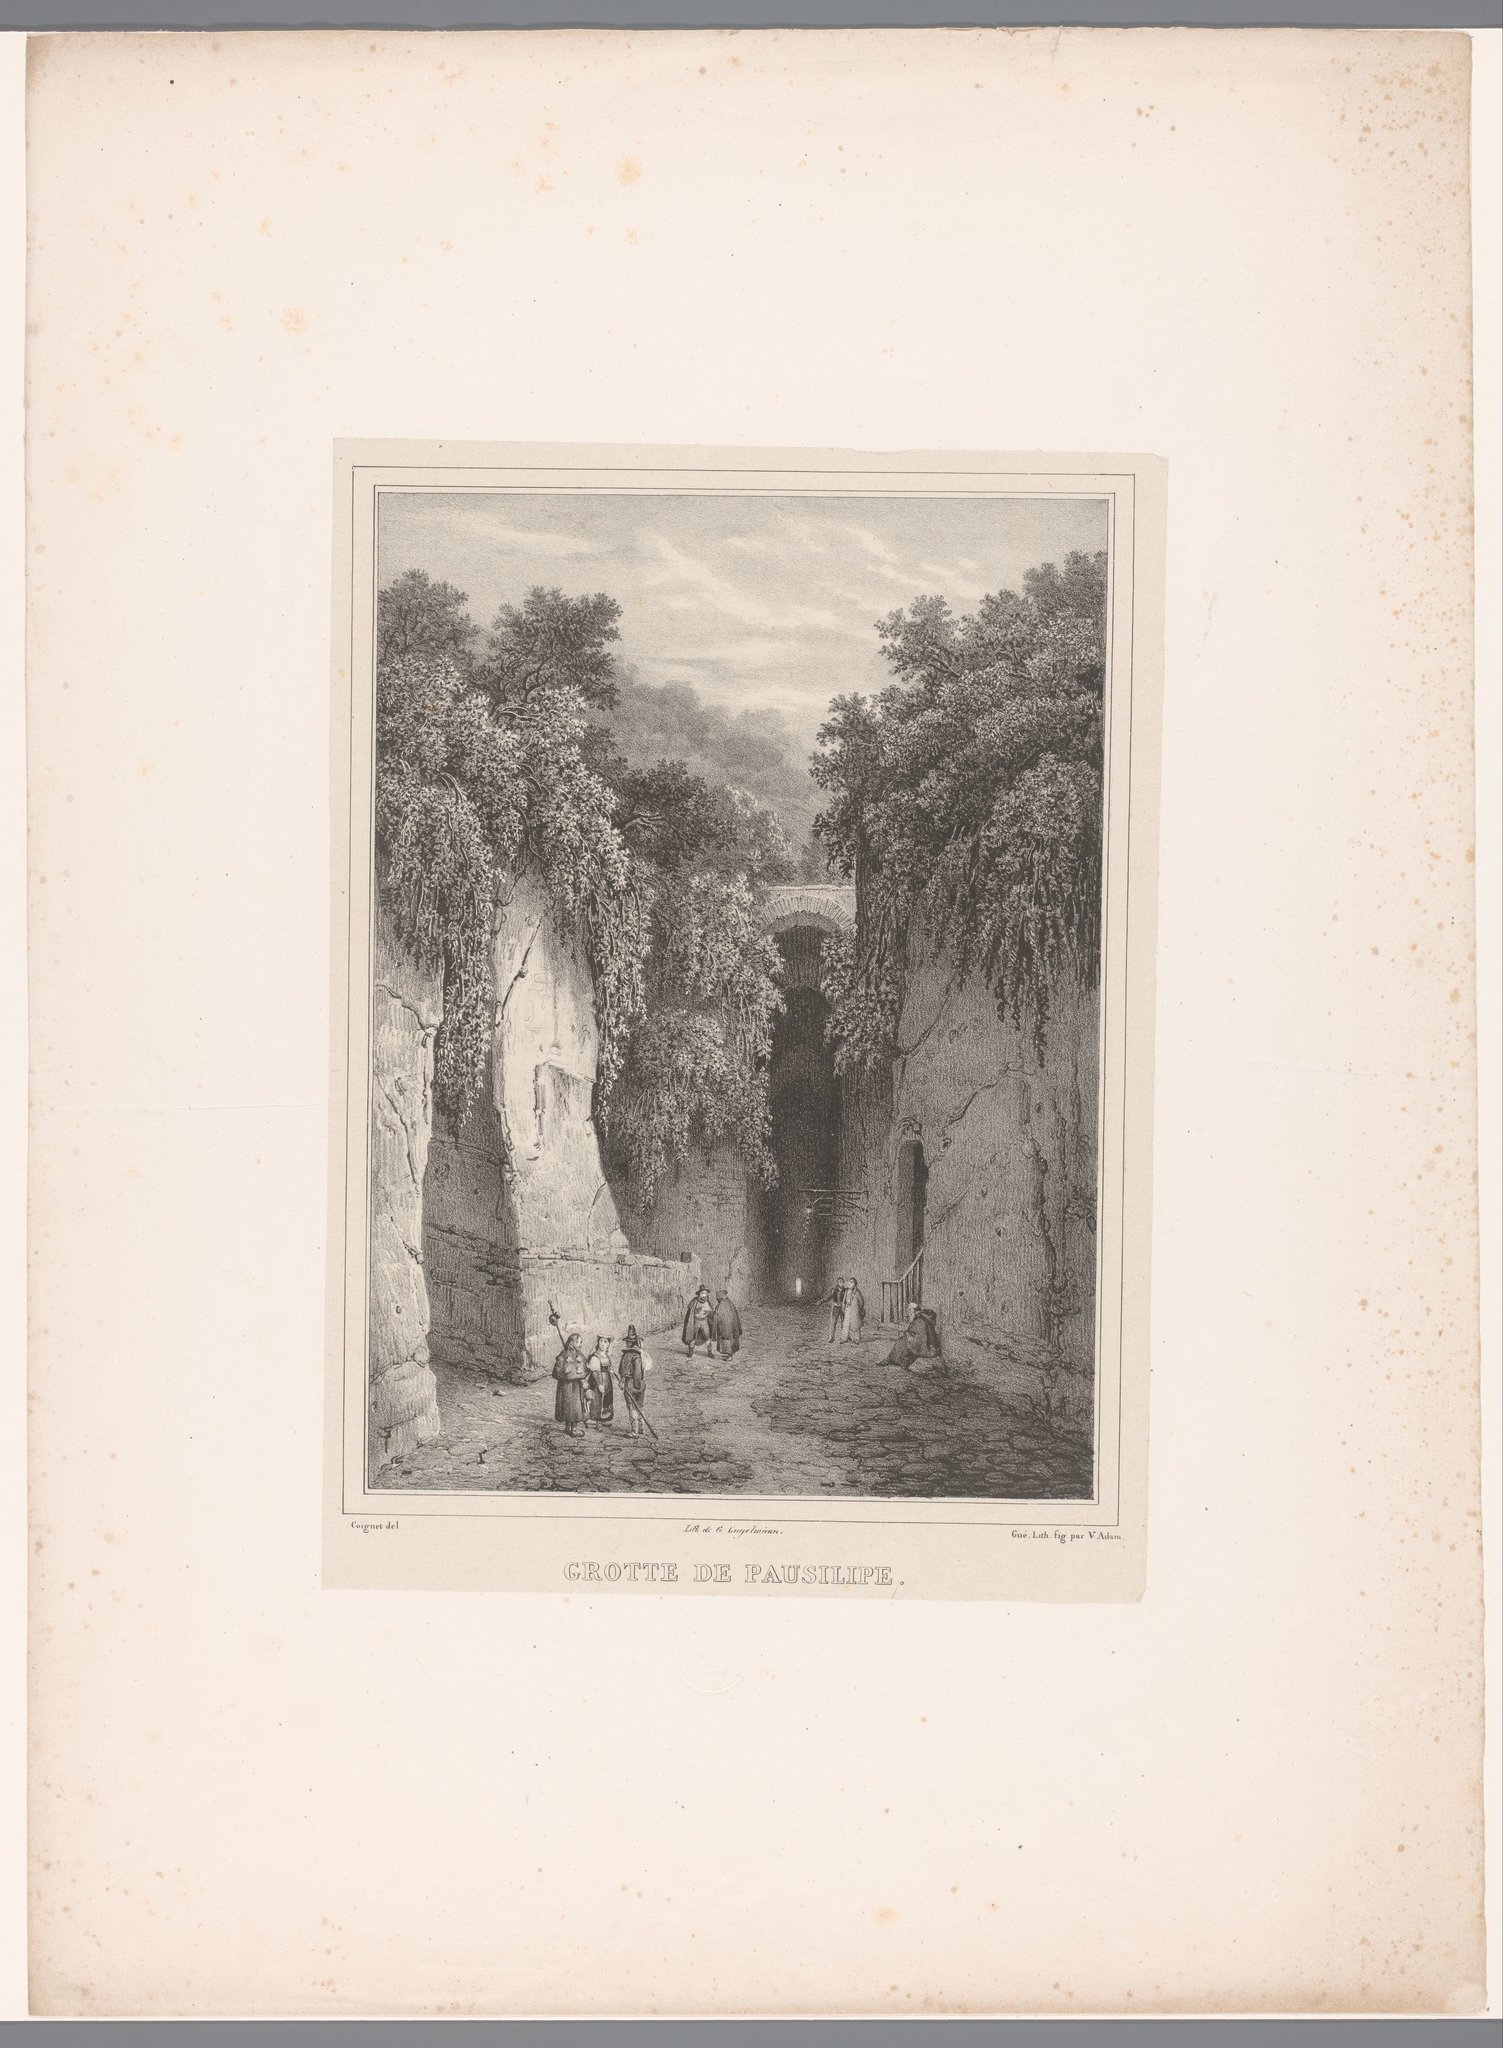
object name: print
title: Grotte de Pausilipe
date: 1830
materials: paper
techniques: lithograph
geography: paris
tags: cave, grotto (+ landscape with figures, staffage), posillipo, collina di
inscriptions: collector's mark: Lugt 2228a, check stamp: Lugt 3431